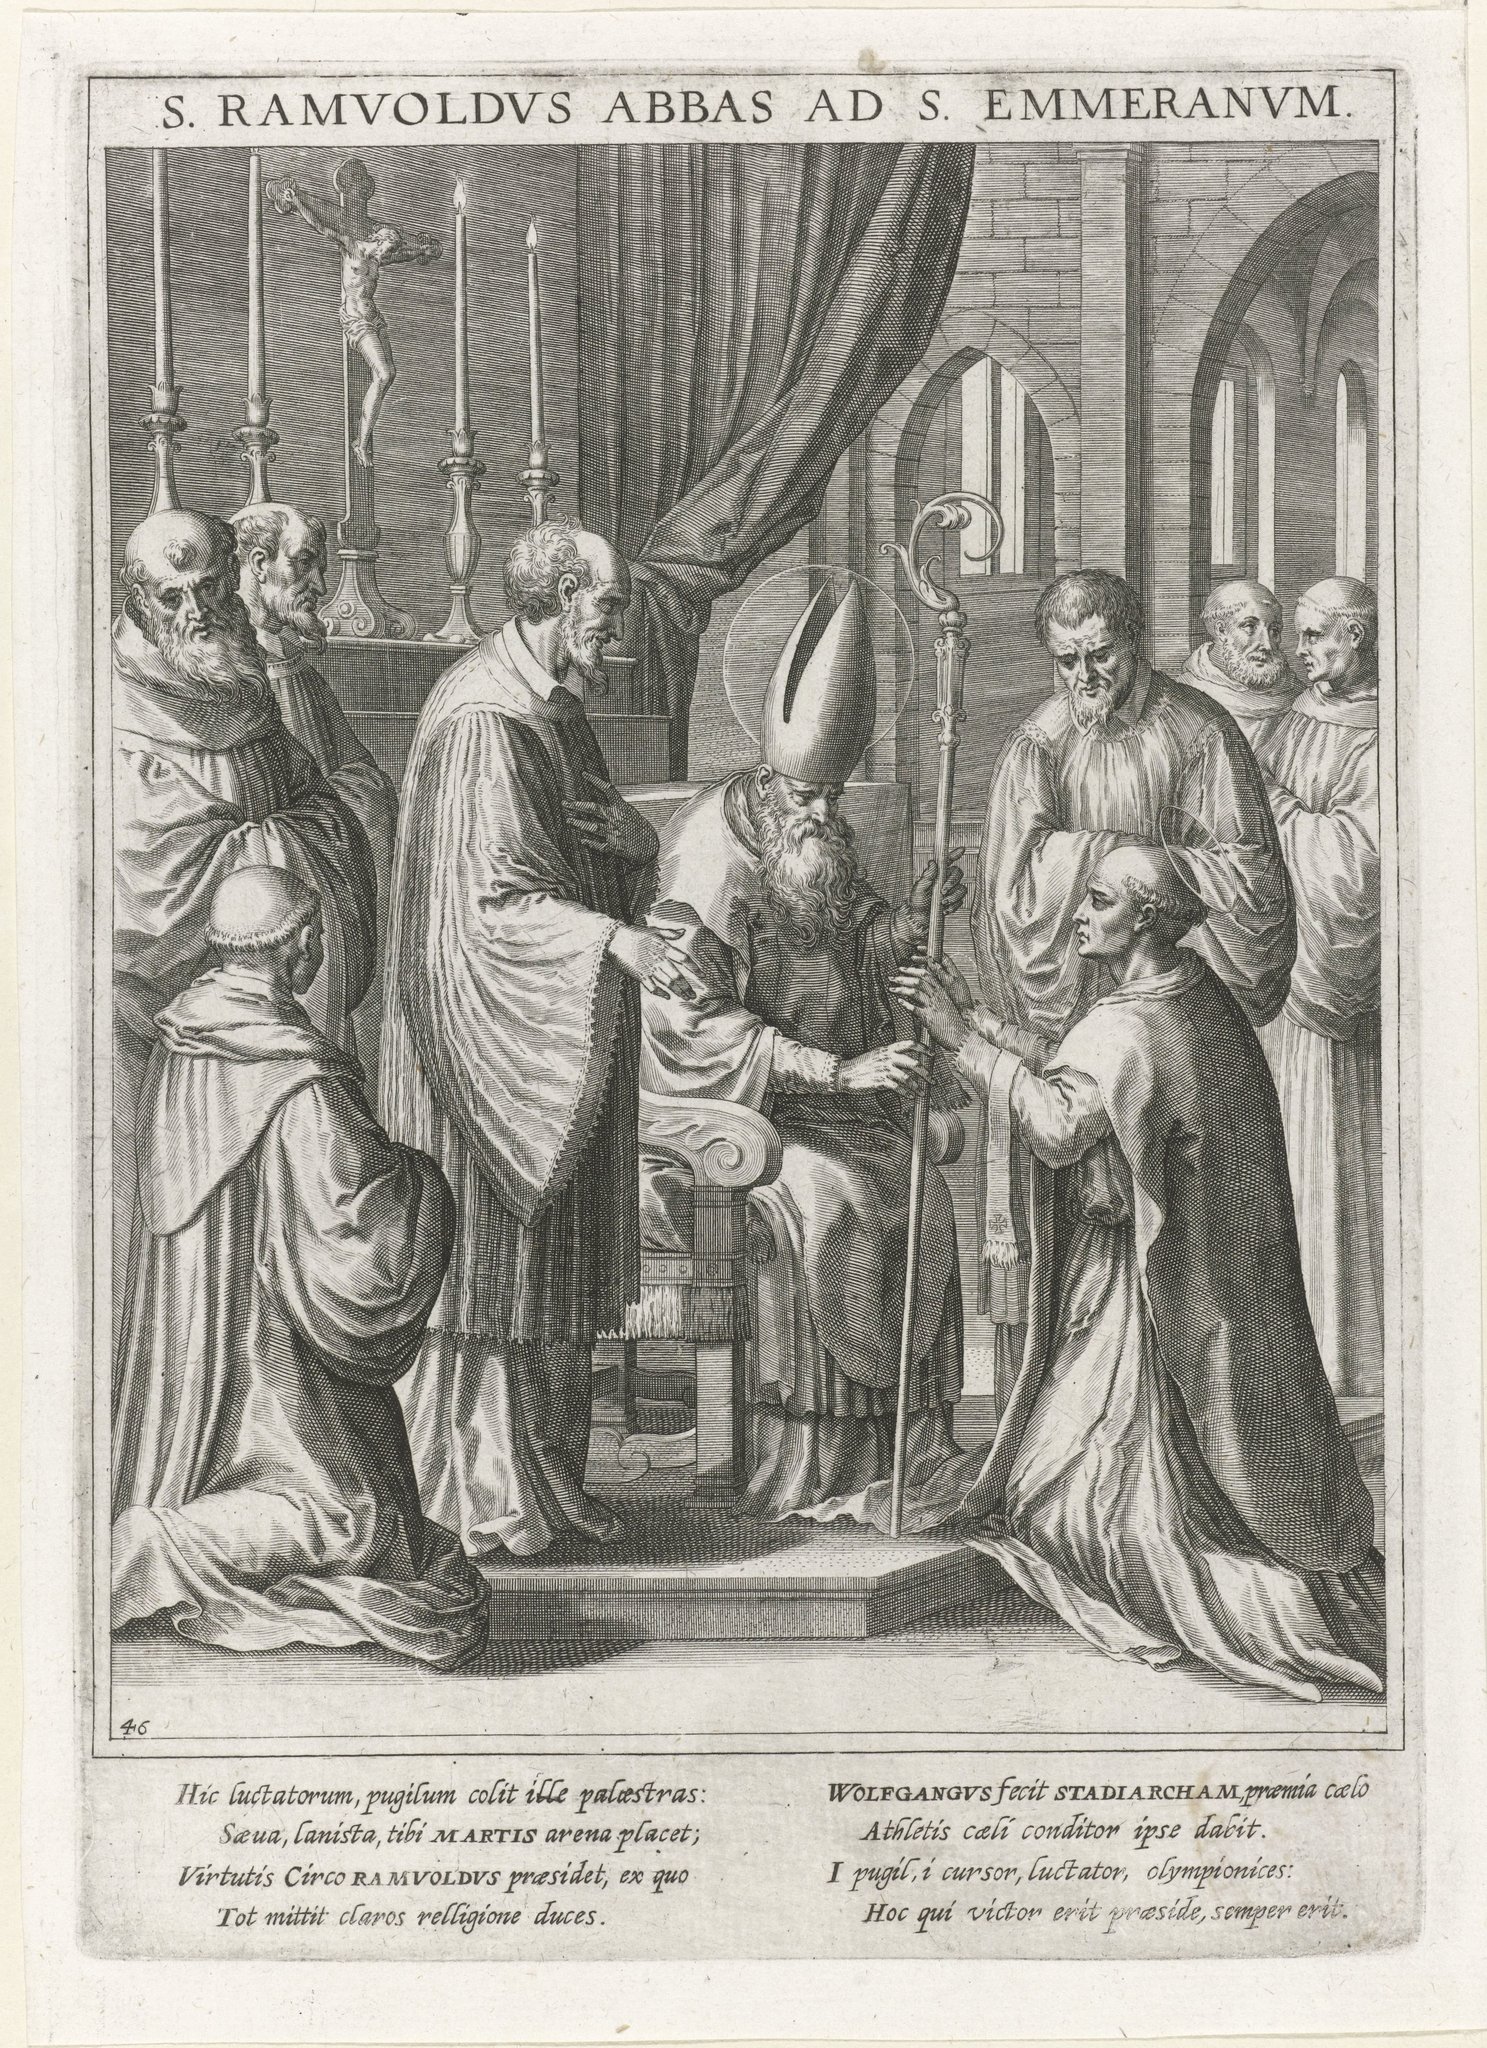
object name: print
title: Bavaria sancta I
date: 1615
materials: paper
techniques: engraving, etching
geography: munich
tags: archbishop, bishop, etc. (roman catholic), saints, monk(s), friar(s), bishop's throne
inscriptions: collector's mark: Lugt 240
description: De H. Ramwold zit geknield voor de bisschopszetel van de H. Wolfgang, bisschop van Regensburg. Hij wordt tot abt van Sankt Emmeram benoemd. De prent heeft een Latijns onderschrift en is de 46ste prent van een 60-delige serie met als onderwerp de heiligen van Beieren.